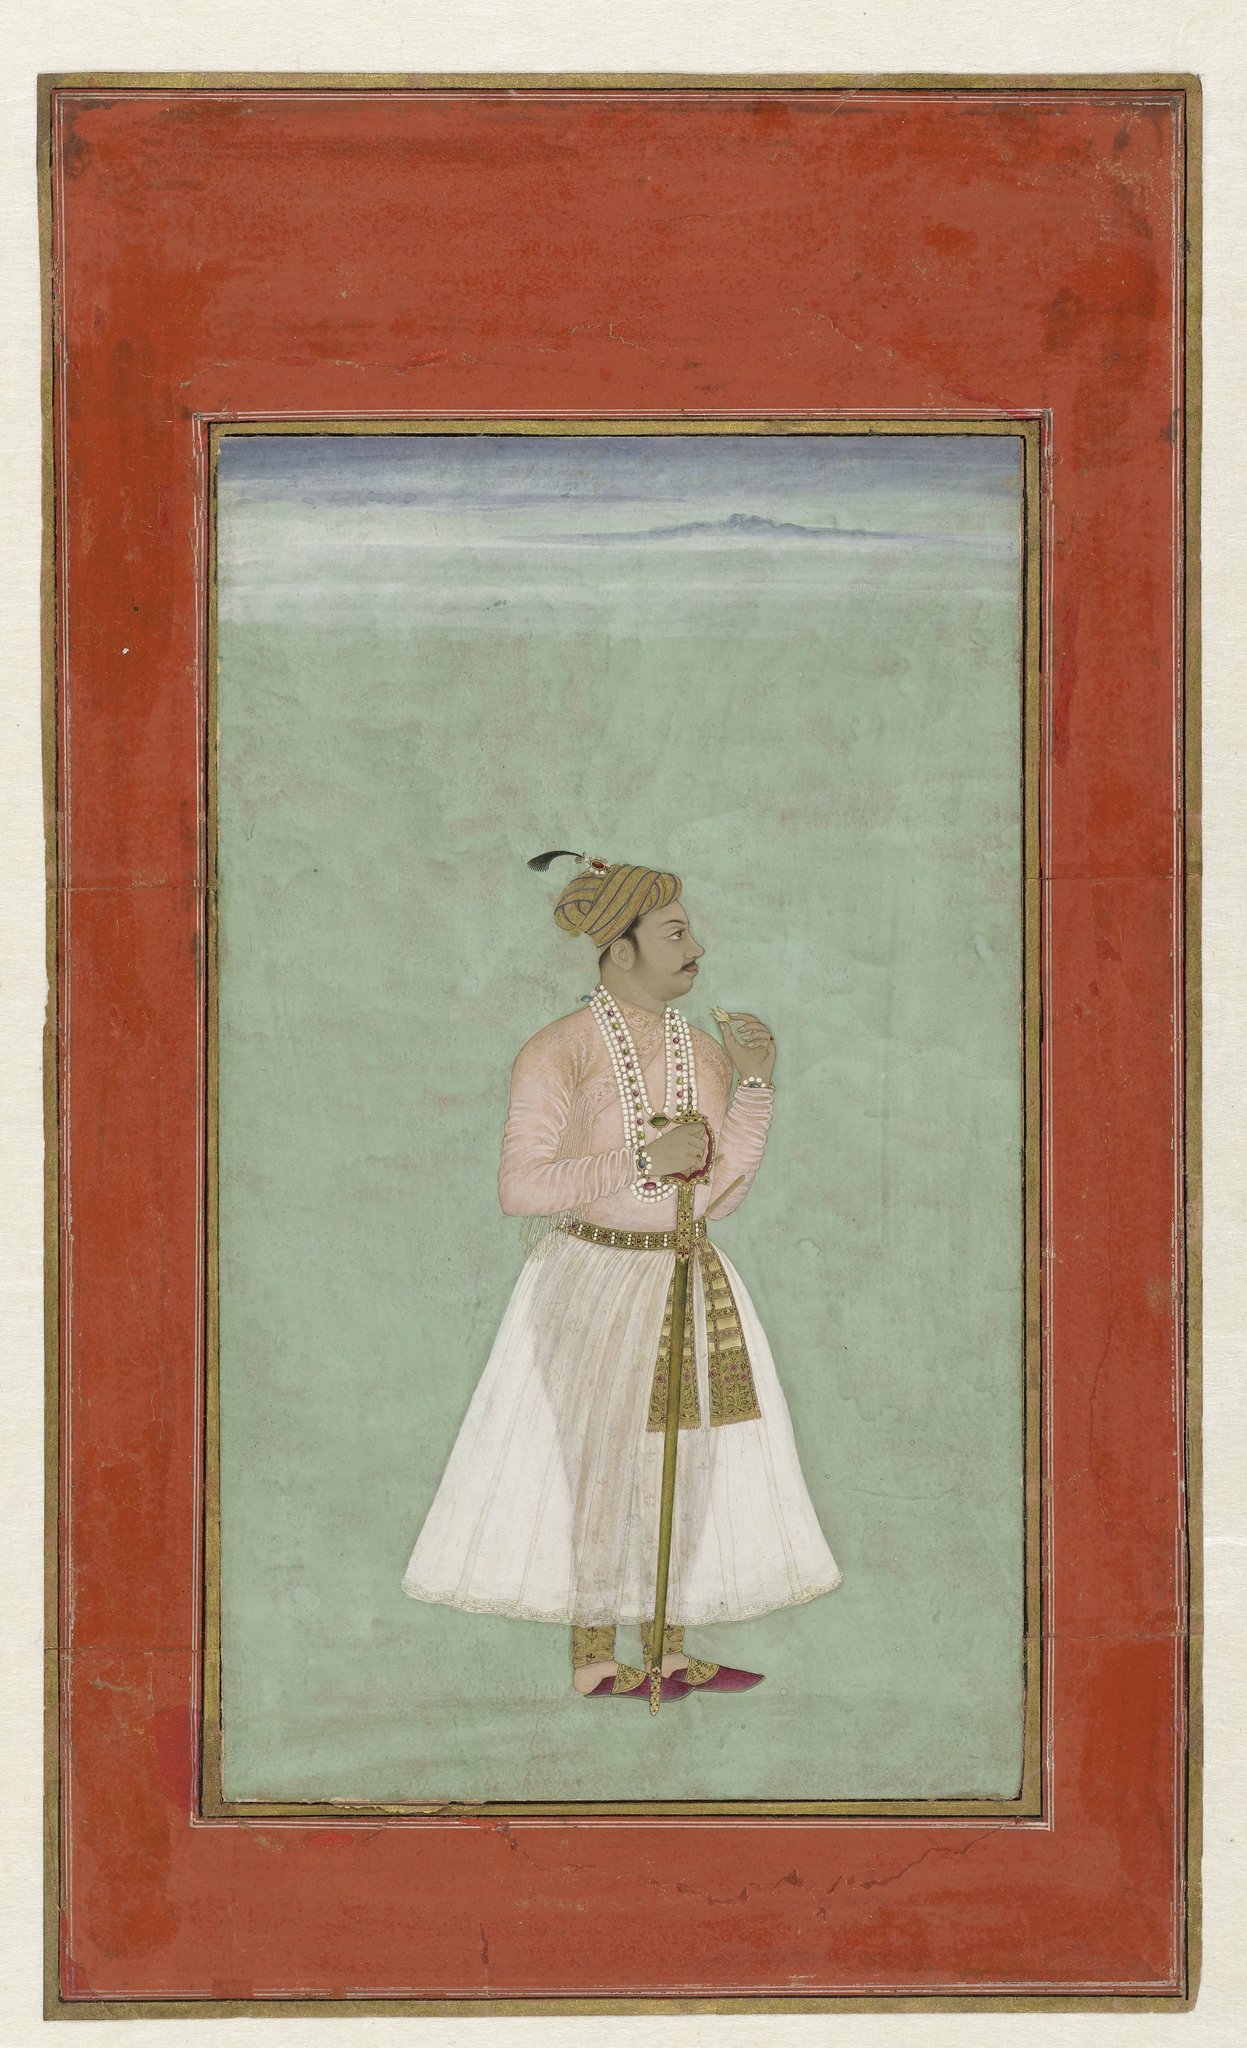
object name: indian miniature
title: Sultan Ali Adil Shah II van Bijapur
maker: ruknuddin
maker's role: draughtsman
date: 1687-1688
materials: paint, gouache, paper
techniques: brush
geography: bikaner